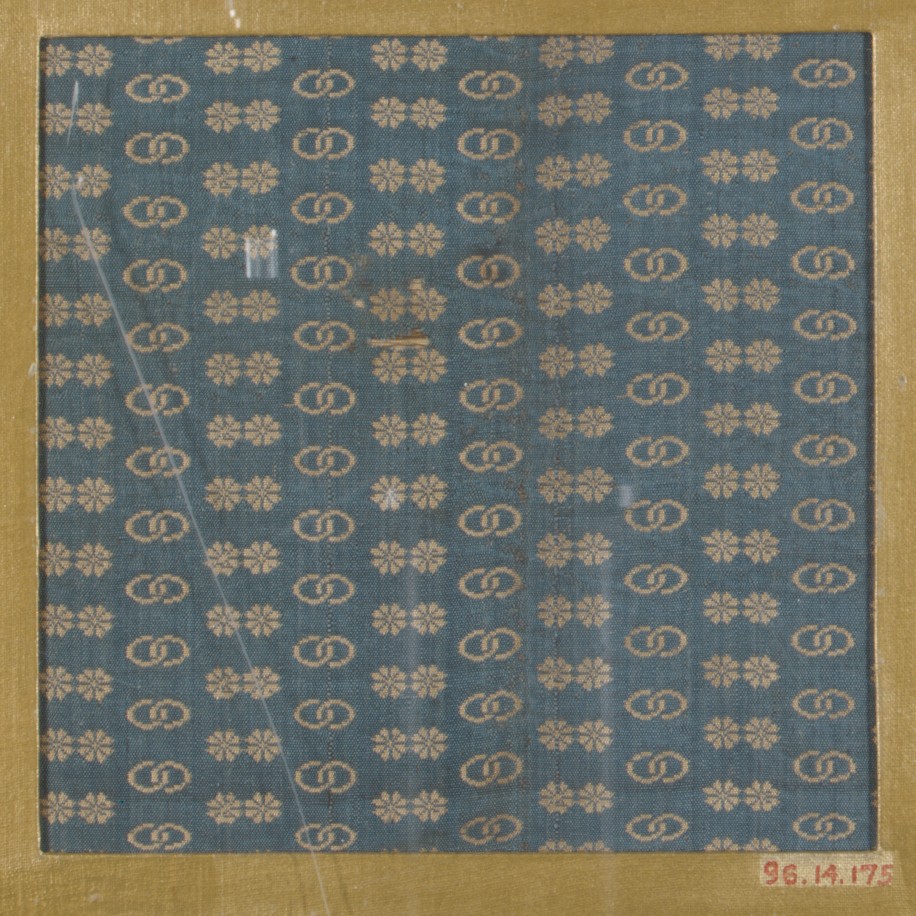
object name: fragment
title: Textile fragment with repeating pattern of paired flowers and linked circles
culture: japanese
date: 1701-1900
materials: silk